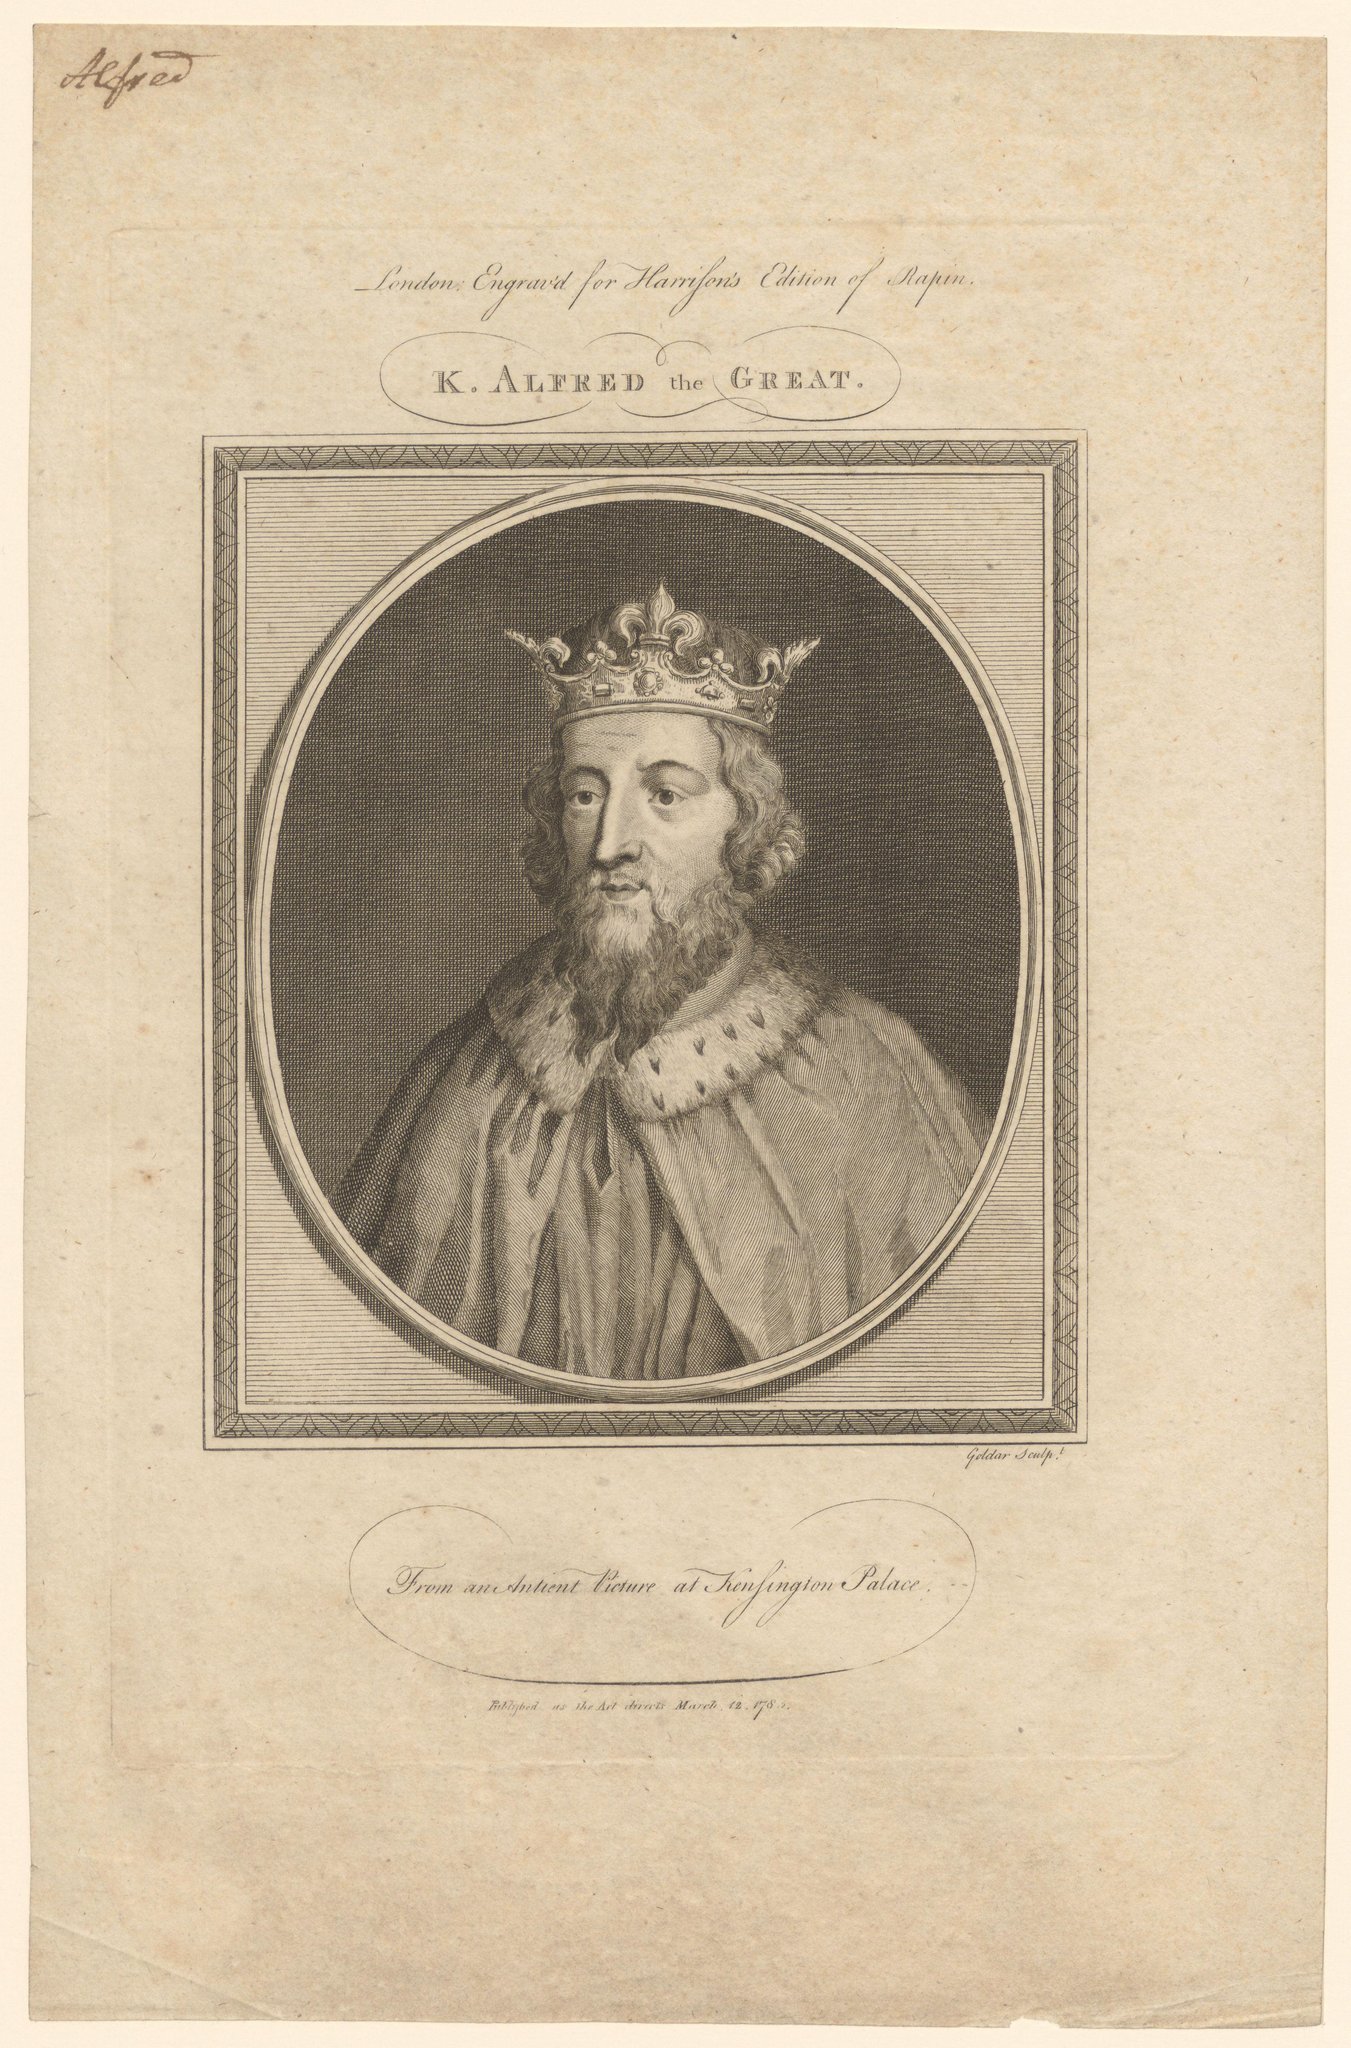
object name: print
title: Portret van Alfred de Grote, koning van Engeland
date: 1785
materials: paper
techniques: engraving, etching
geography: england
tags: historical persons, king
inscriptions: collector's mark: Lugt 2228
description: Prent is gebruikt in: Rapin, Paul de. History of England. [Vertaald uit het Frans door] Nicolas Tindal. Londen: John Harrison, 1785.